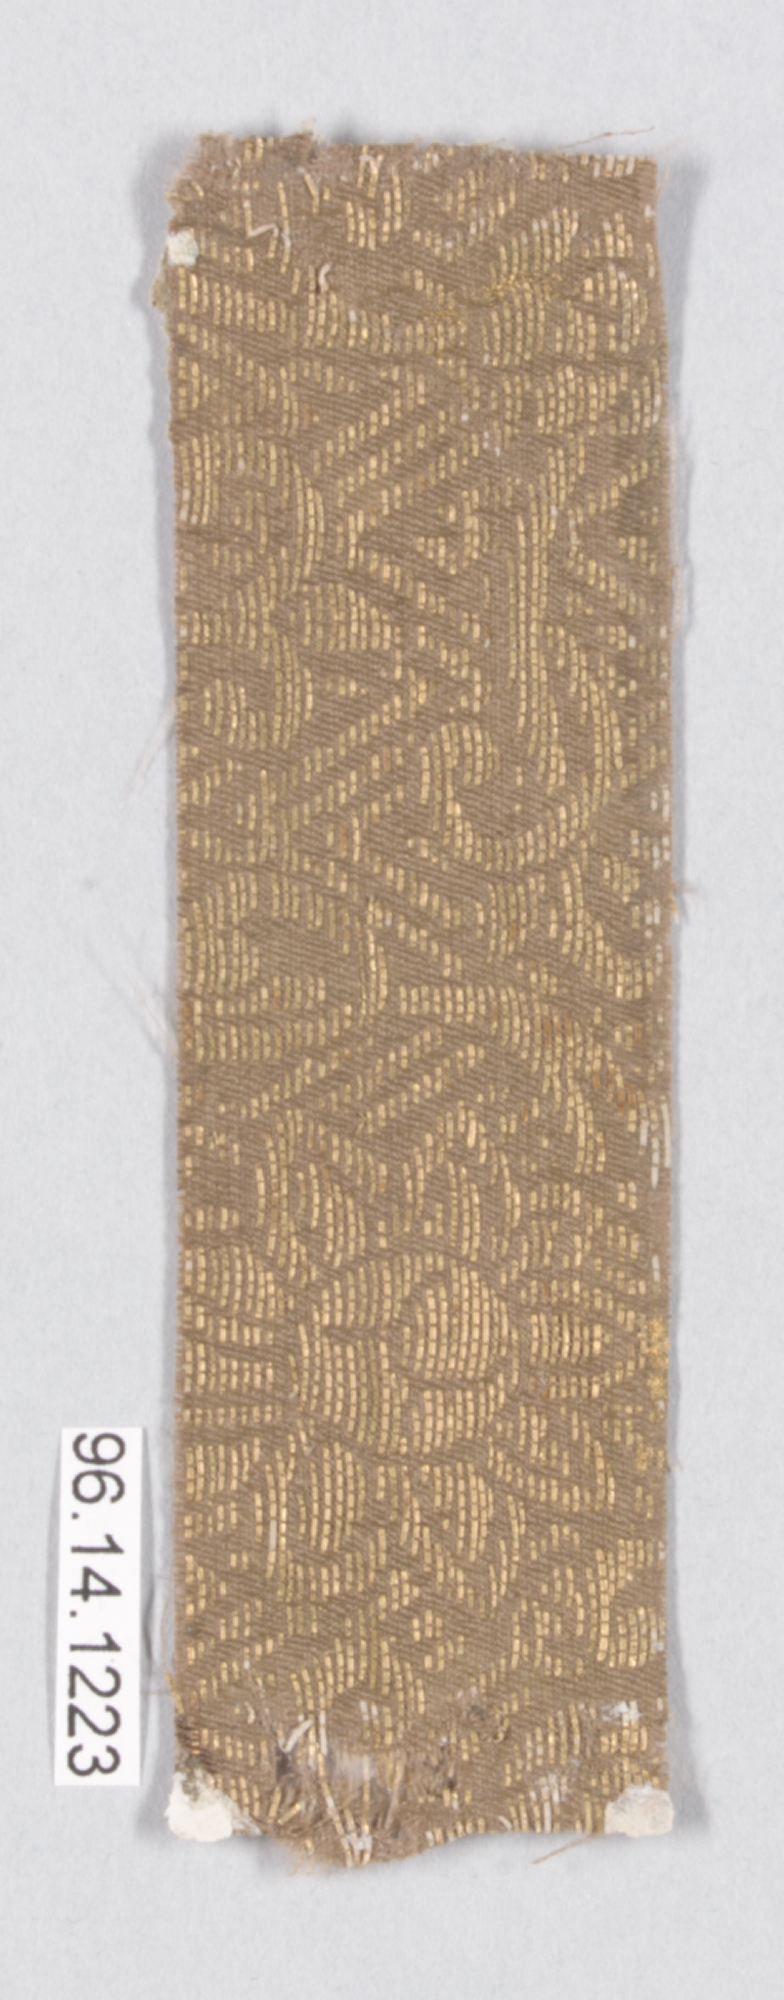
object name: piece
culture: japanese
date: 1701-1900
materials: silk